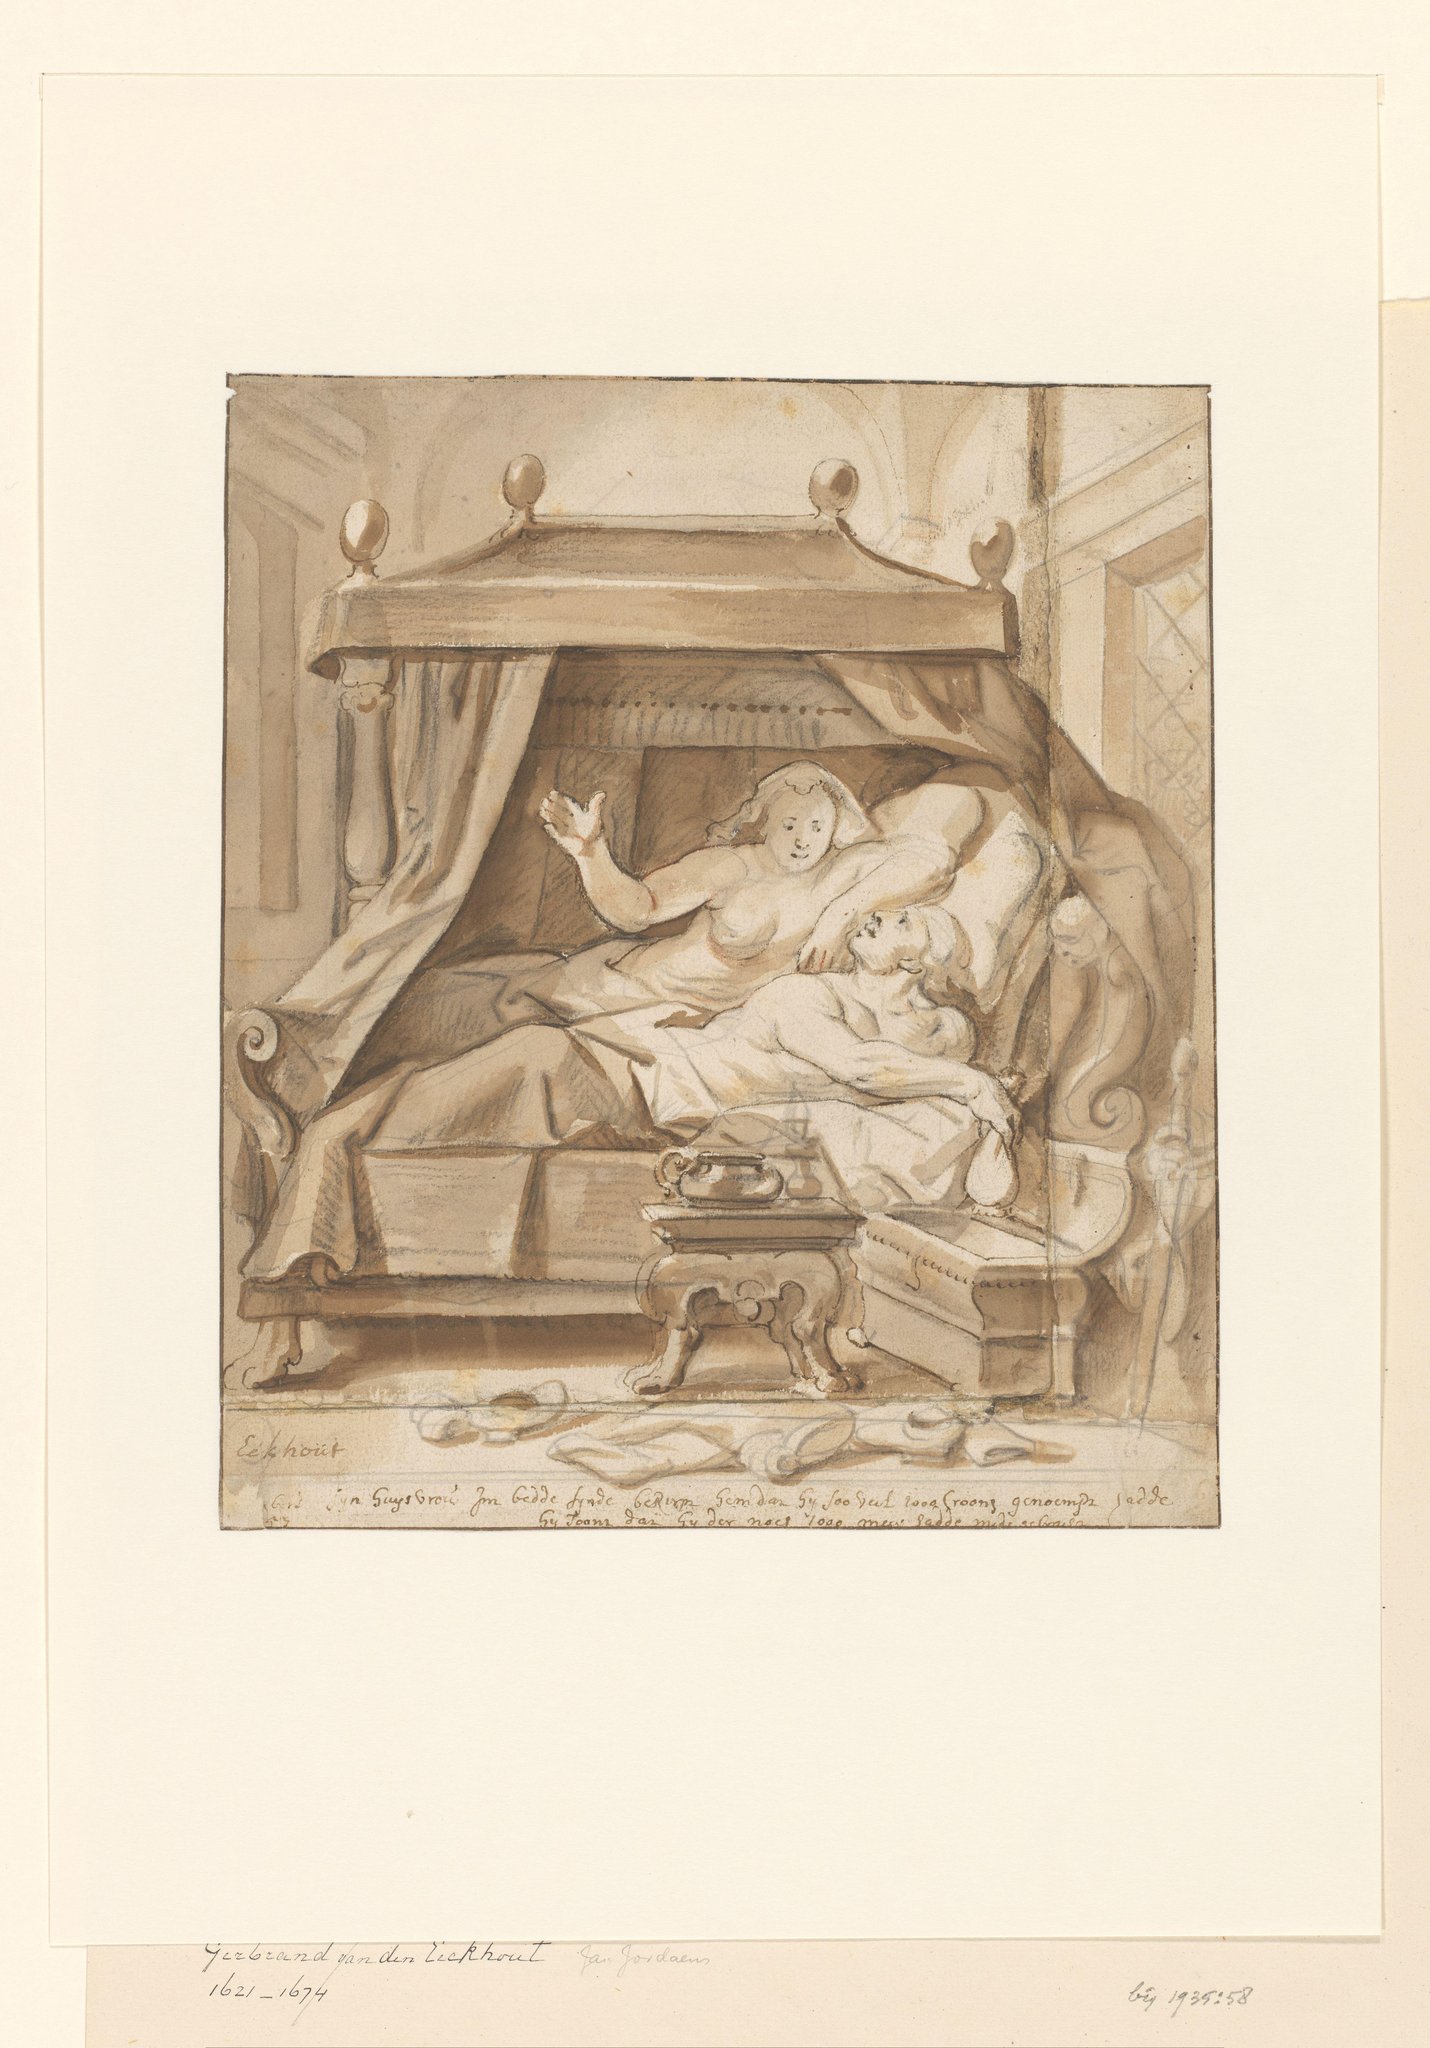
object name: drawing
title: Cavarra en Euripia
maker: jacques jordaens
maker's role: designer, draughtsman, painter, print maker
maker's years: 1593-1678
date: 1657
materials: graphite, ink, paper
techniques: brush, pen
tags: male characters from arthurian legend : use 82a(...)